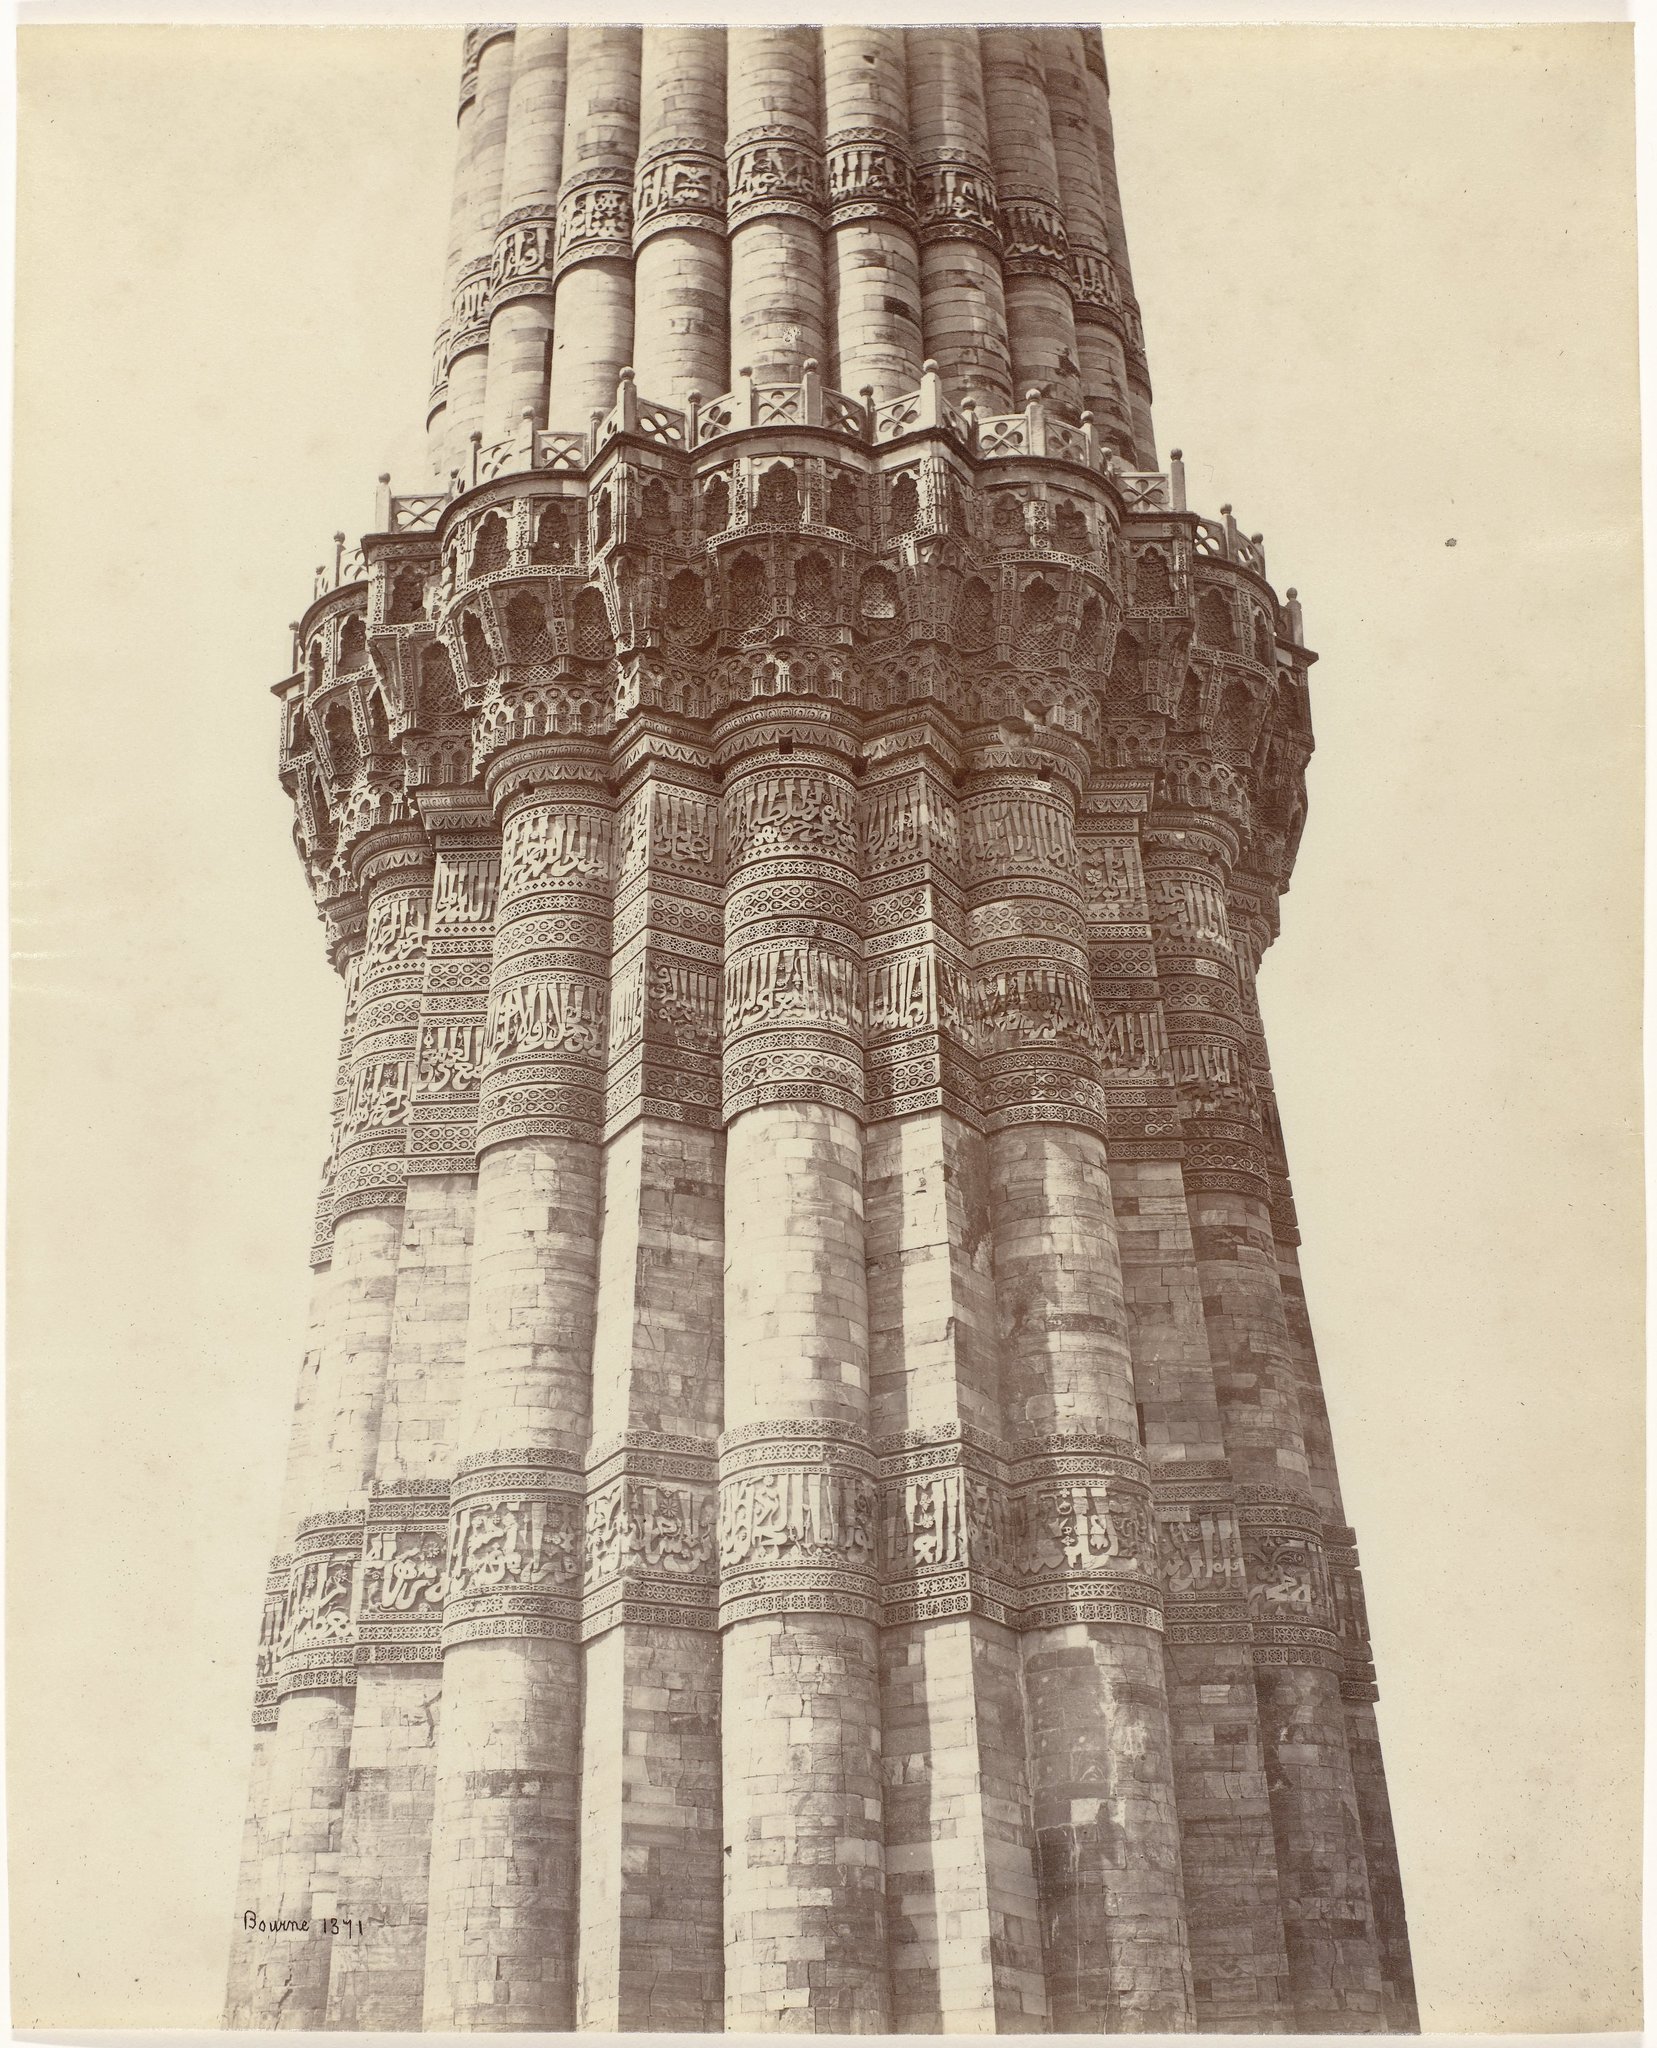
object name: photograph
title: The first gallery of the Qutb Minar in Delhi, India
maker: samuel bourne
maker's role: fotograaf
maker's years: 1834-1912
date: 1863-1866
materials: paper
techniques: albumen print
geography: delhi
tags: carving ~ applied arts, tower, clock tower ~ monumental adornment, temple, shrine ~ islam, mohammedanism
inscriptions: number: ‘1248/ 1371/ 75,-’, number: ‘1371’, name: ‘Bourne’